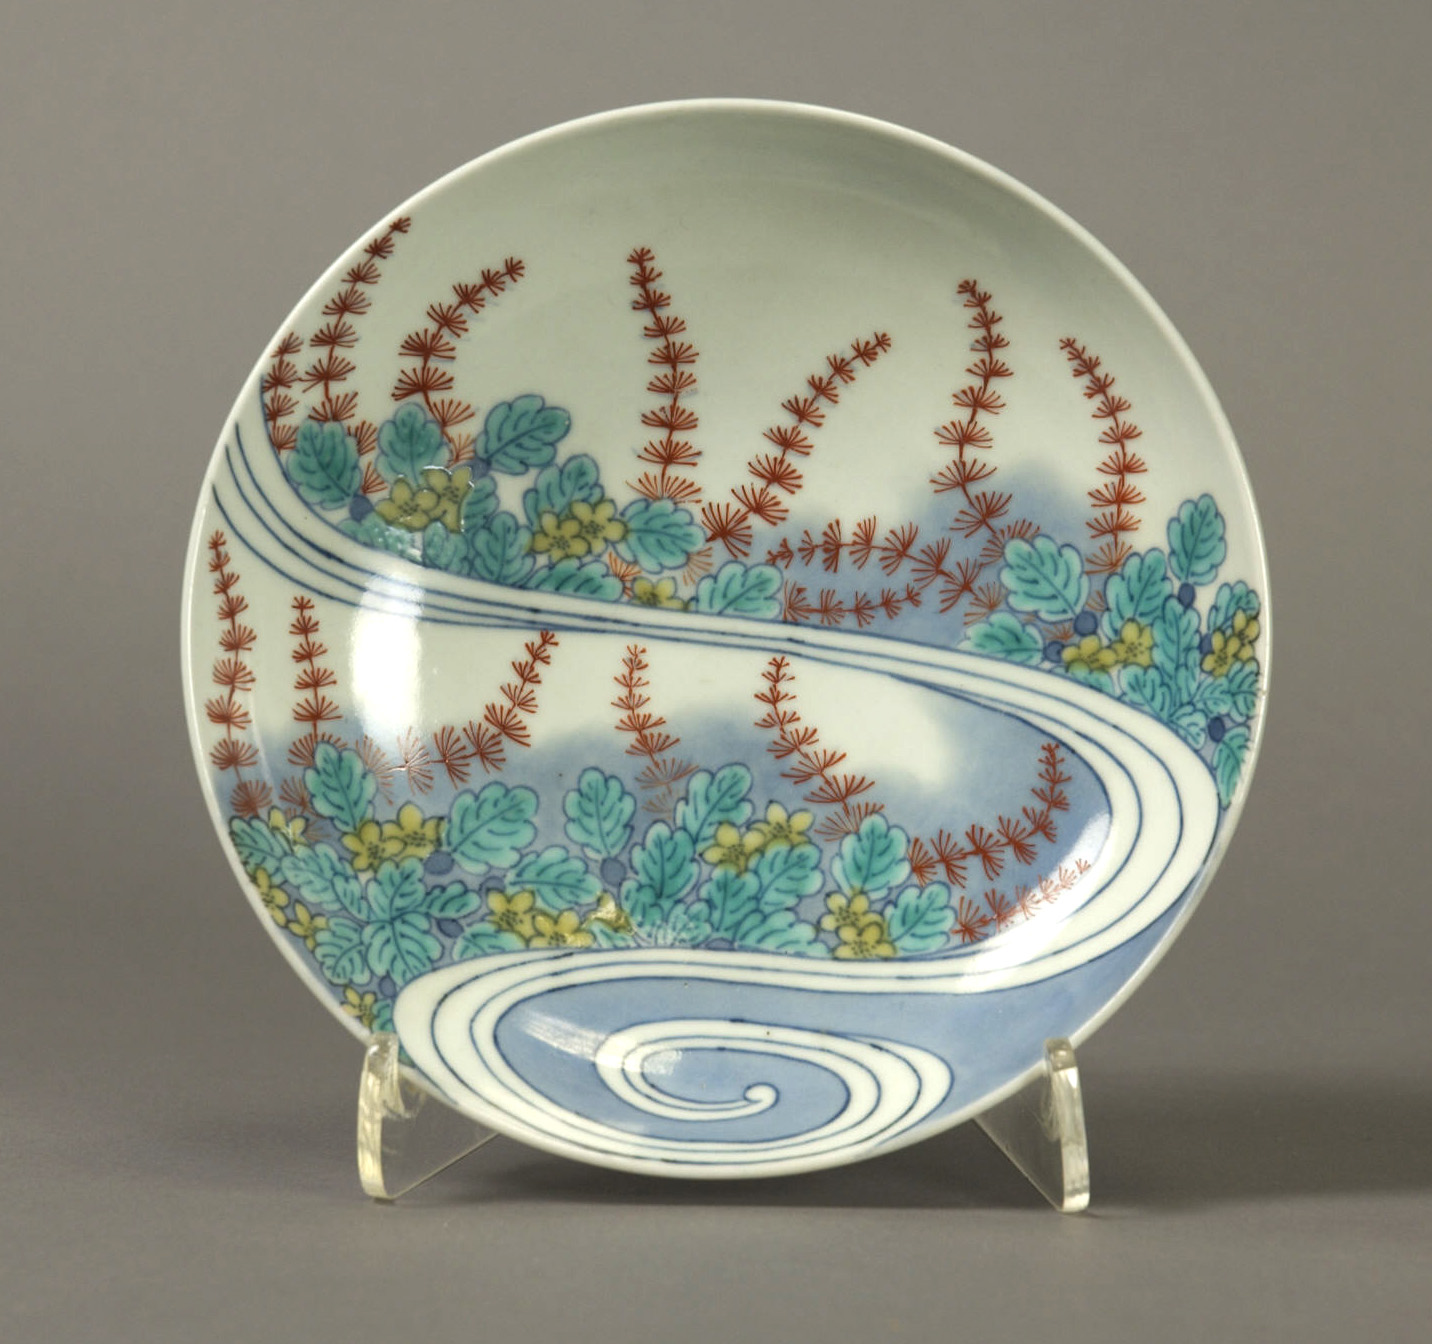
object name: dish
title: Dish with Design of Water Plants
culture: japanese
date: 1701-1733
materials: enamel, porcelain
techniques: overglaze, underglaze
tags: leaves